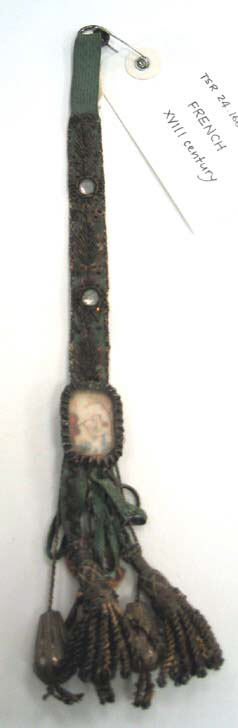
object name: fob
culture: french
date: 1701-1800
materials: metal thread, silk